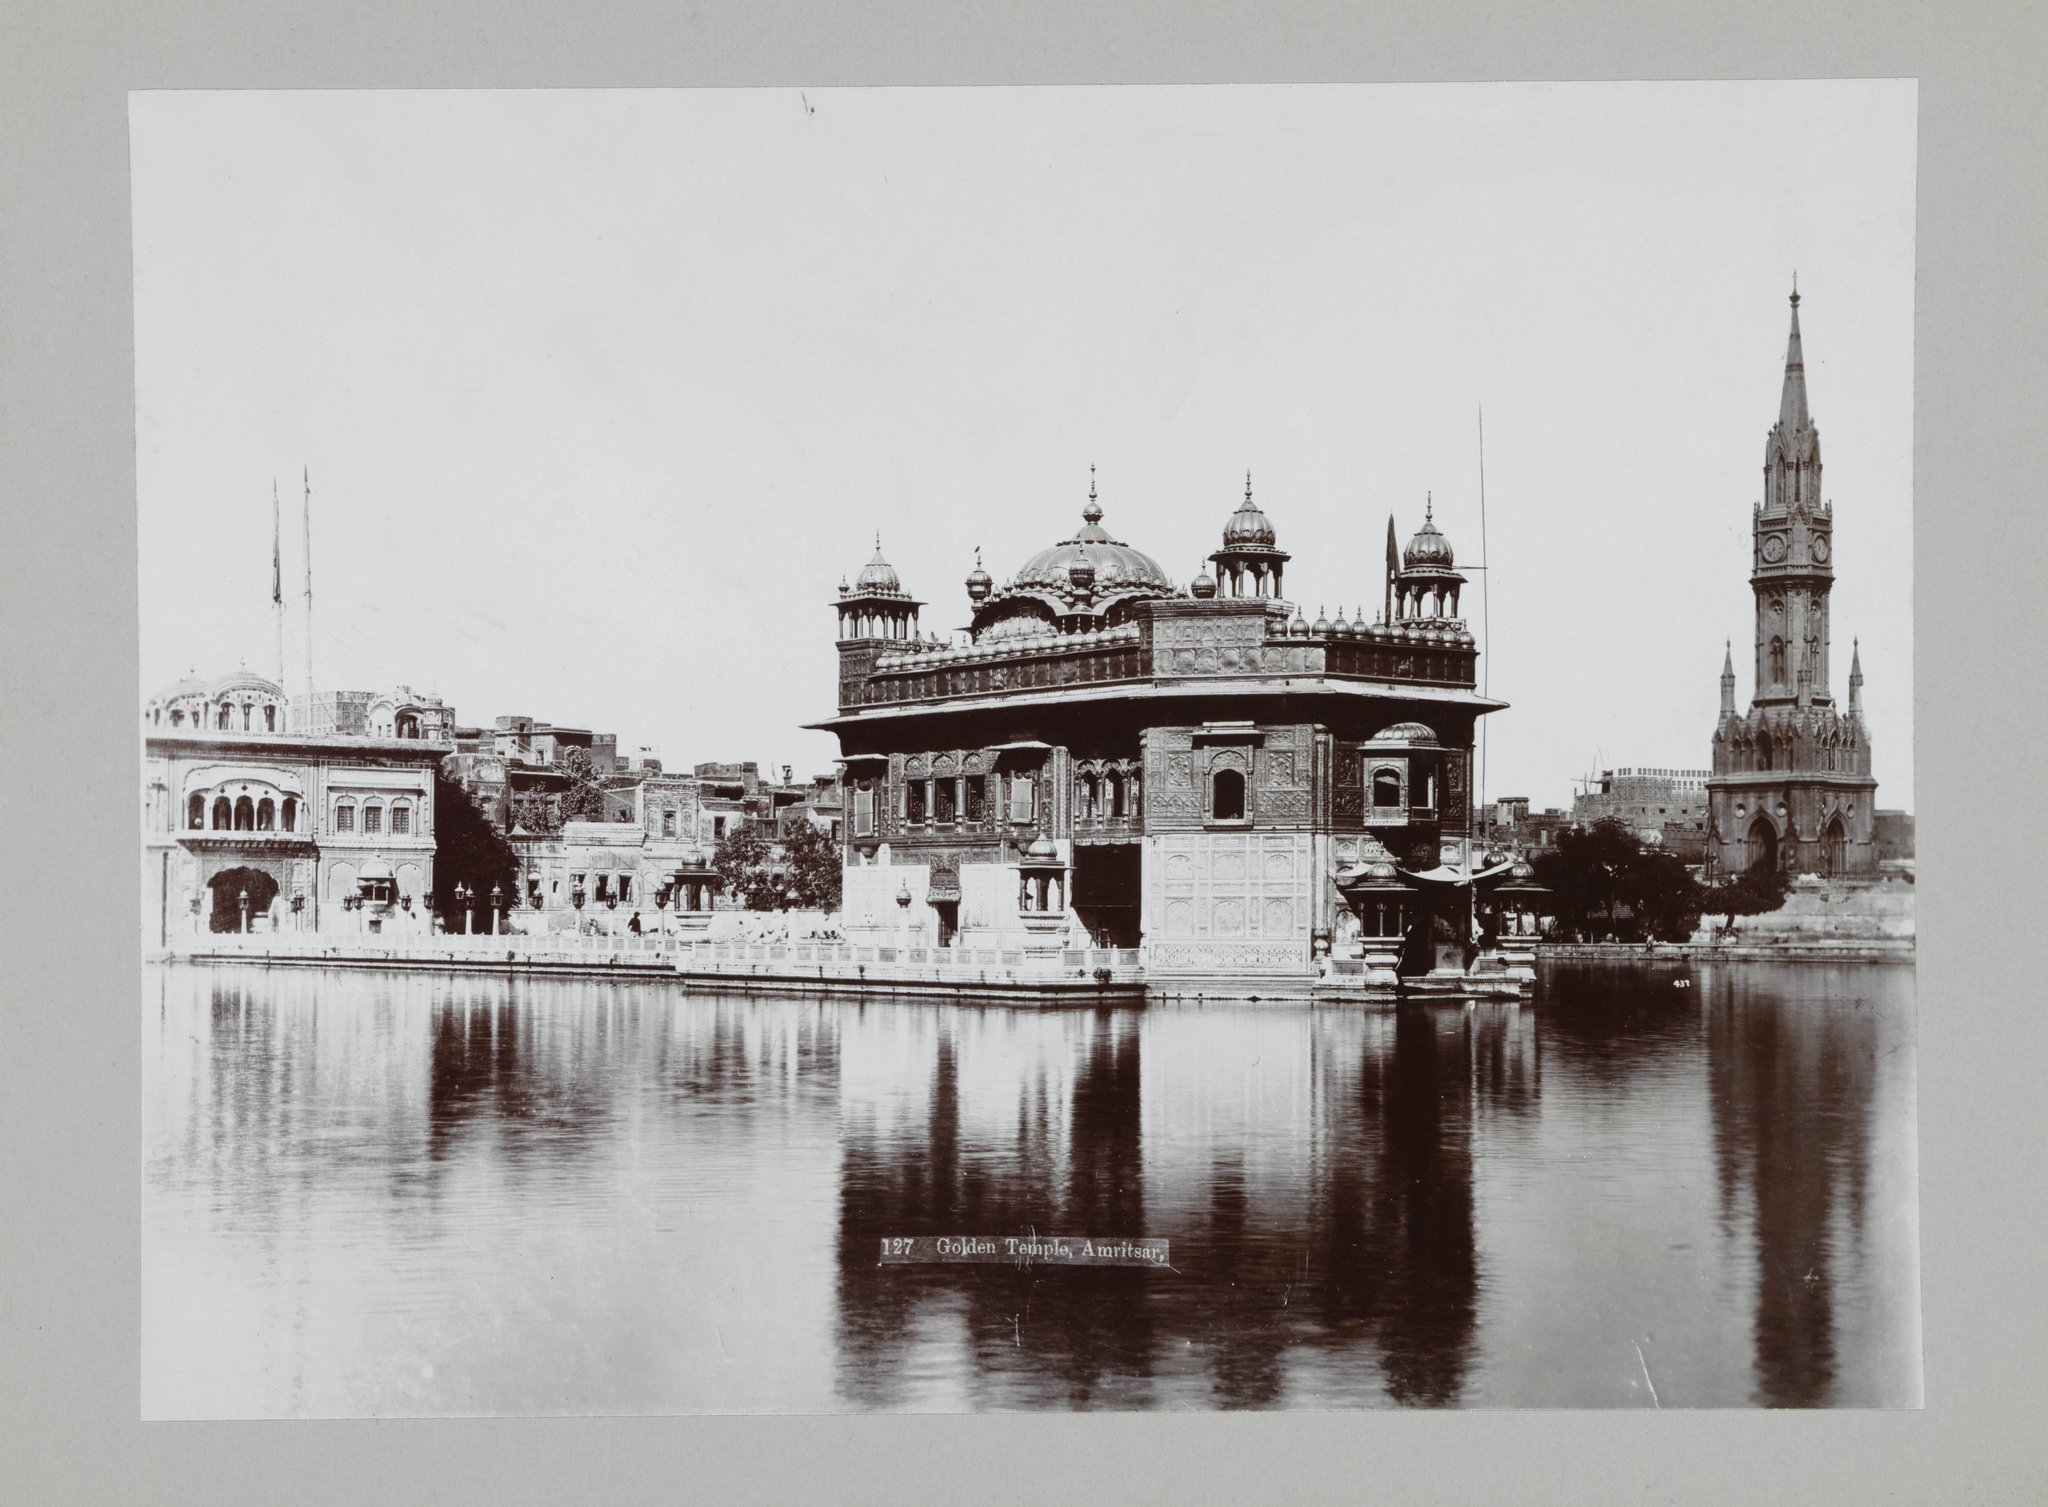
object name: photograph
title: The Golden Temple in Amritsar, Punjab, India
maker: Anonymous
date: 1895-1915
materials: cardboard, paper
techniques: gelatin silver print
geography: amritsar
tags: amritsar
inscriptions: number: ‘19.’, inscription: ‘127 Golden Temple, Amritsar,’